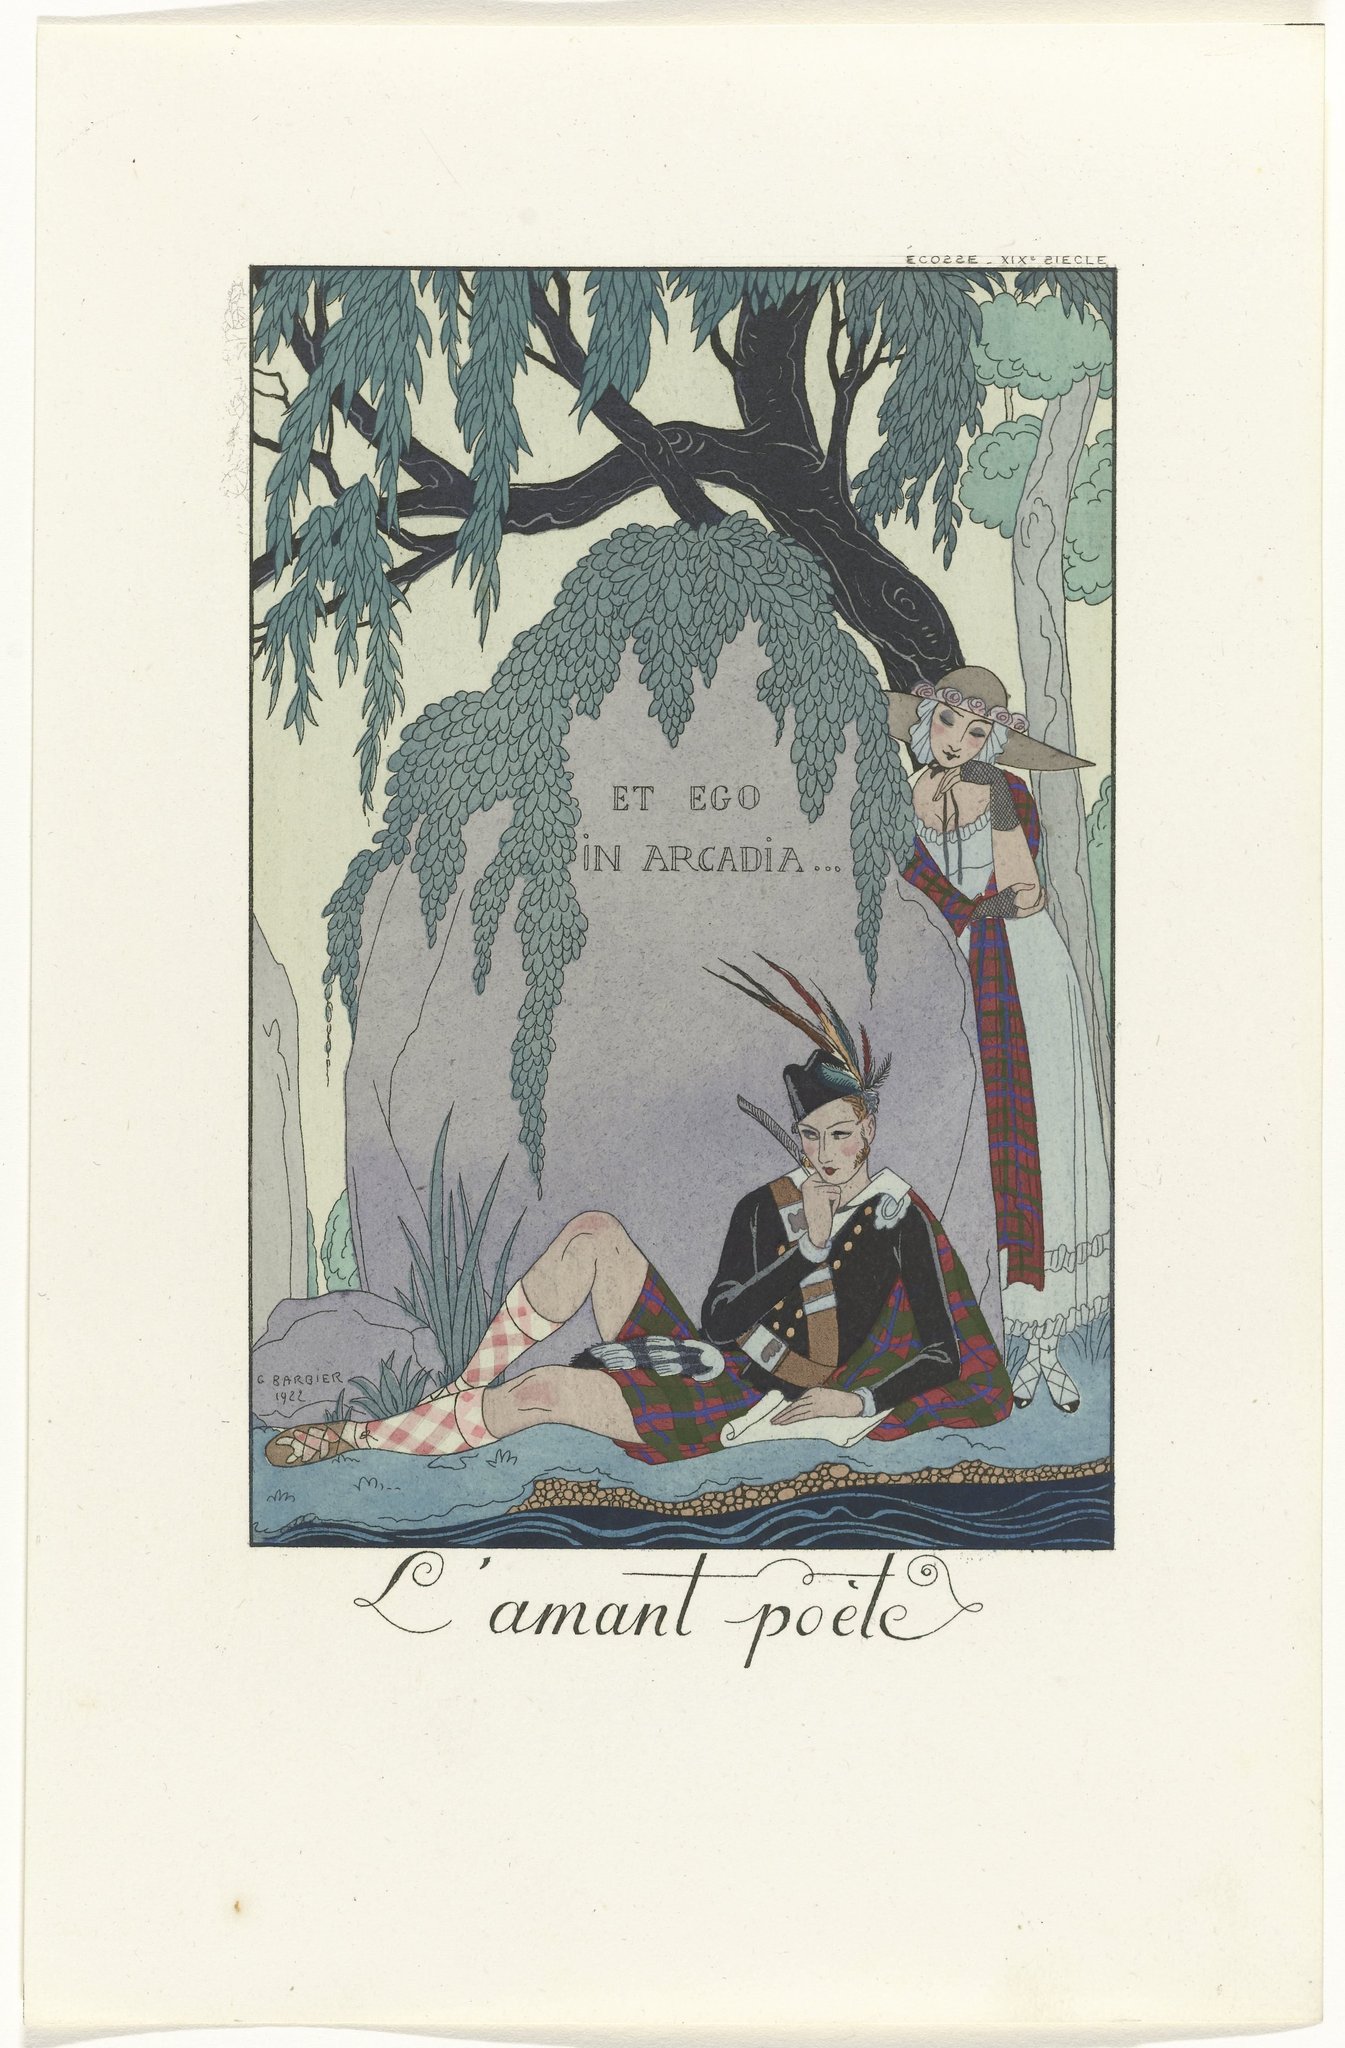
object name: fashion print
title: Falbalas et Fanfreluches: almanach des modes présentes, passées & futures pour 1923, 2e année: L'amant poète. / Écosse XIXe siècle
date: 1922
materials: paper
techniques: hand coloring, lithograph, pochoir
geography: paris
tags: clothing for the upper part of the body (shawl) (+ women's clothes), gloves, mittens (mitaines) (+ women's clothes), writing tools, head-gear: hat (+ men's clothes), fashion plates, head-gear: hat (+ women's clothes), dress, gown (+ women's clothes), writer, poet, author, stockings, socks (+ men's clothes)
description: Dichter in Schotse kleding, zittend voor een rotsblok met de tekst "Et ego in Arcadia". Prent uit de serie Falbalas & Fanfreluches (1922-1926).